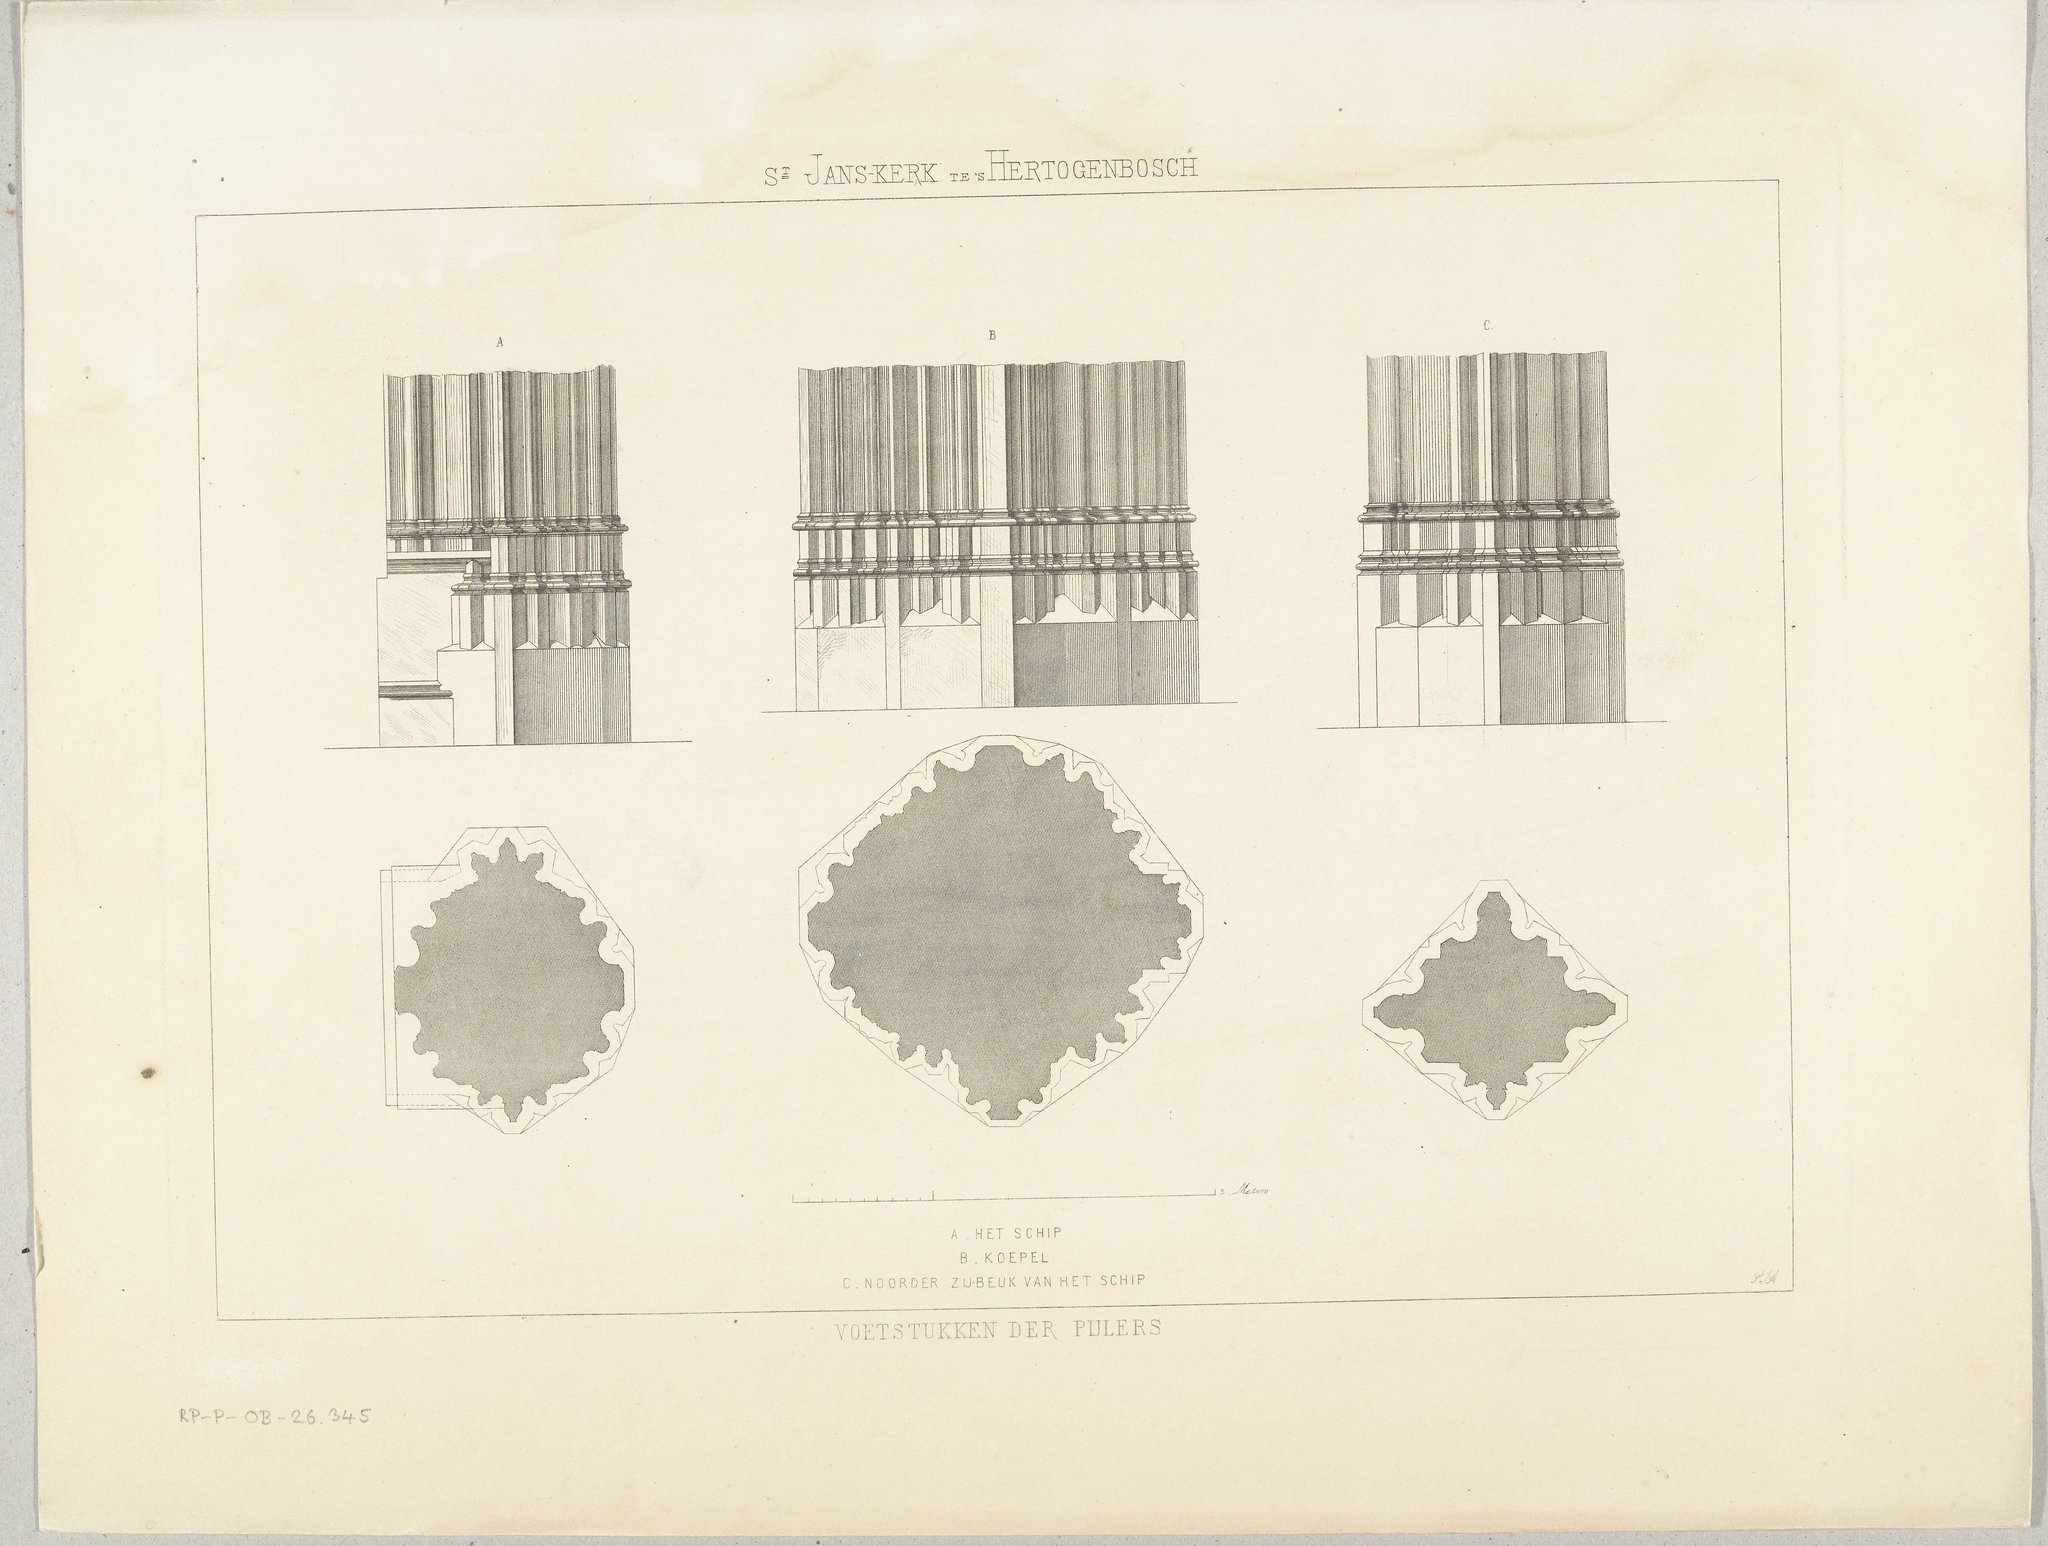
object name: print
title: Doorsnede en zijaanzicht van pilaar-voetstukken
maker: petrus johannes arendzen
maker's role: draughtsman, print maker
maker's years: 1846-1932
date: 1875-1895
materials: paper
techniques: engraving, etching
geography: netherlands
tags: sint-janskathedraal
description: Waarschijnlijk afkomstig uit: J.C.A. Hezenmans, De St. Jans-kerk te 's-Hertogenbosch, uitg. door het Provinciaal Genootschap voor Kunsten en Wetenschappen in Noord-Brabant, 's-Hertogenbosch : Muller, [1895]